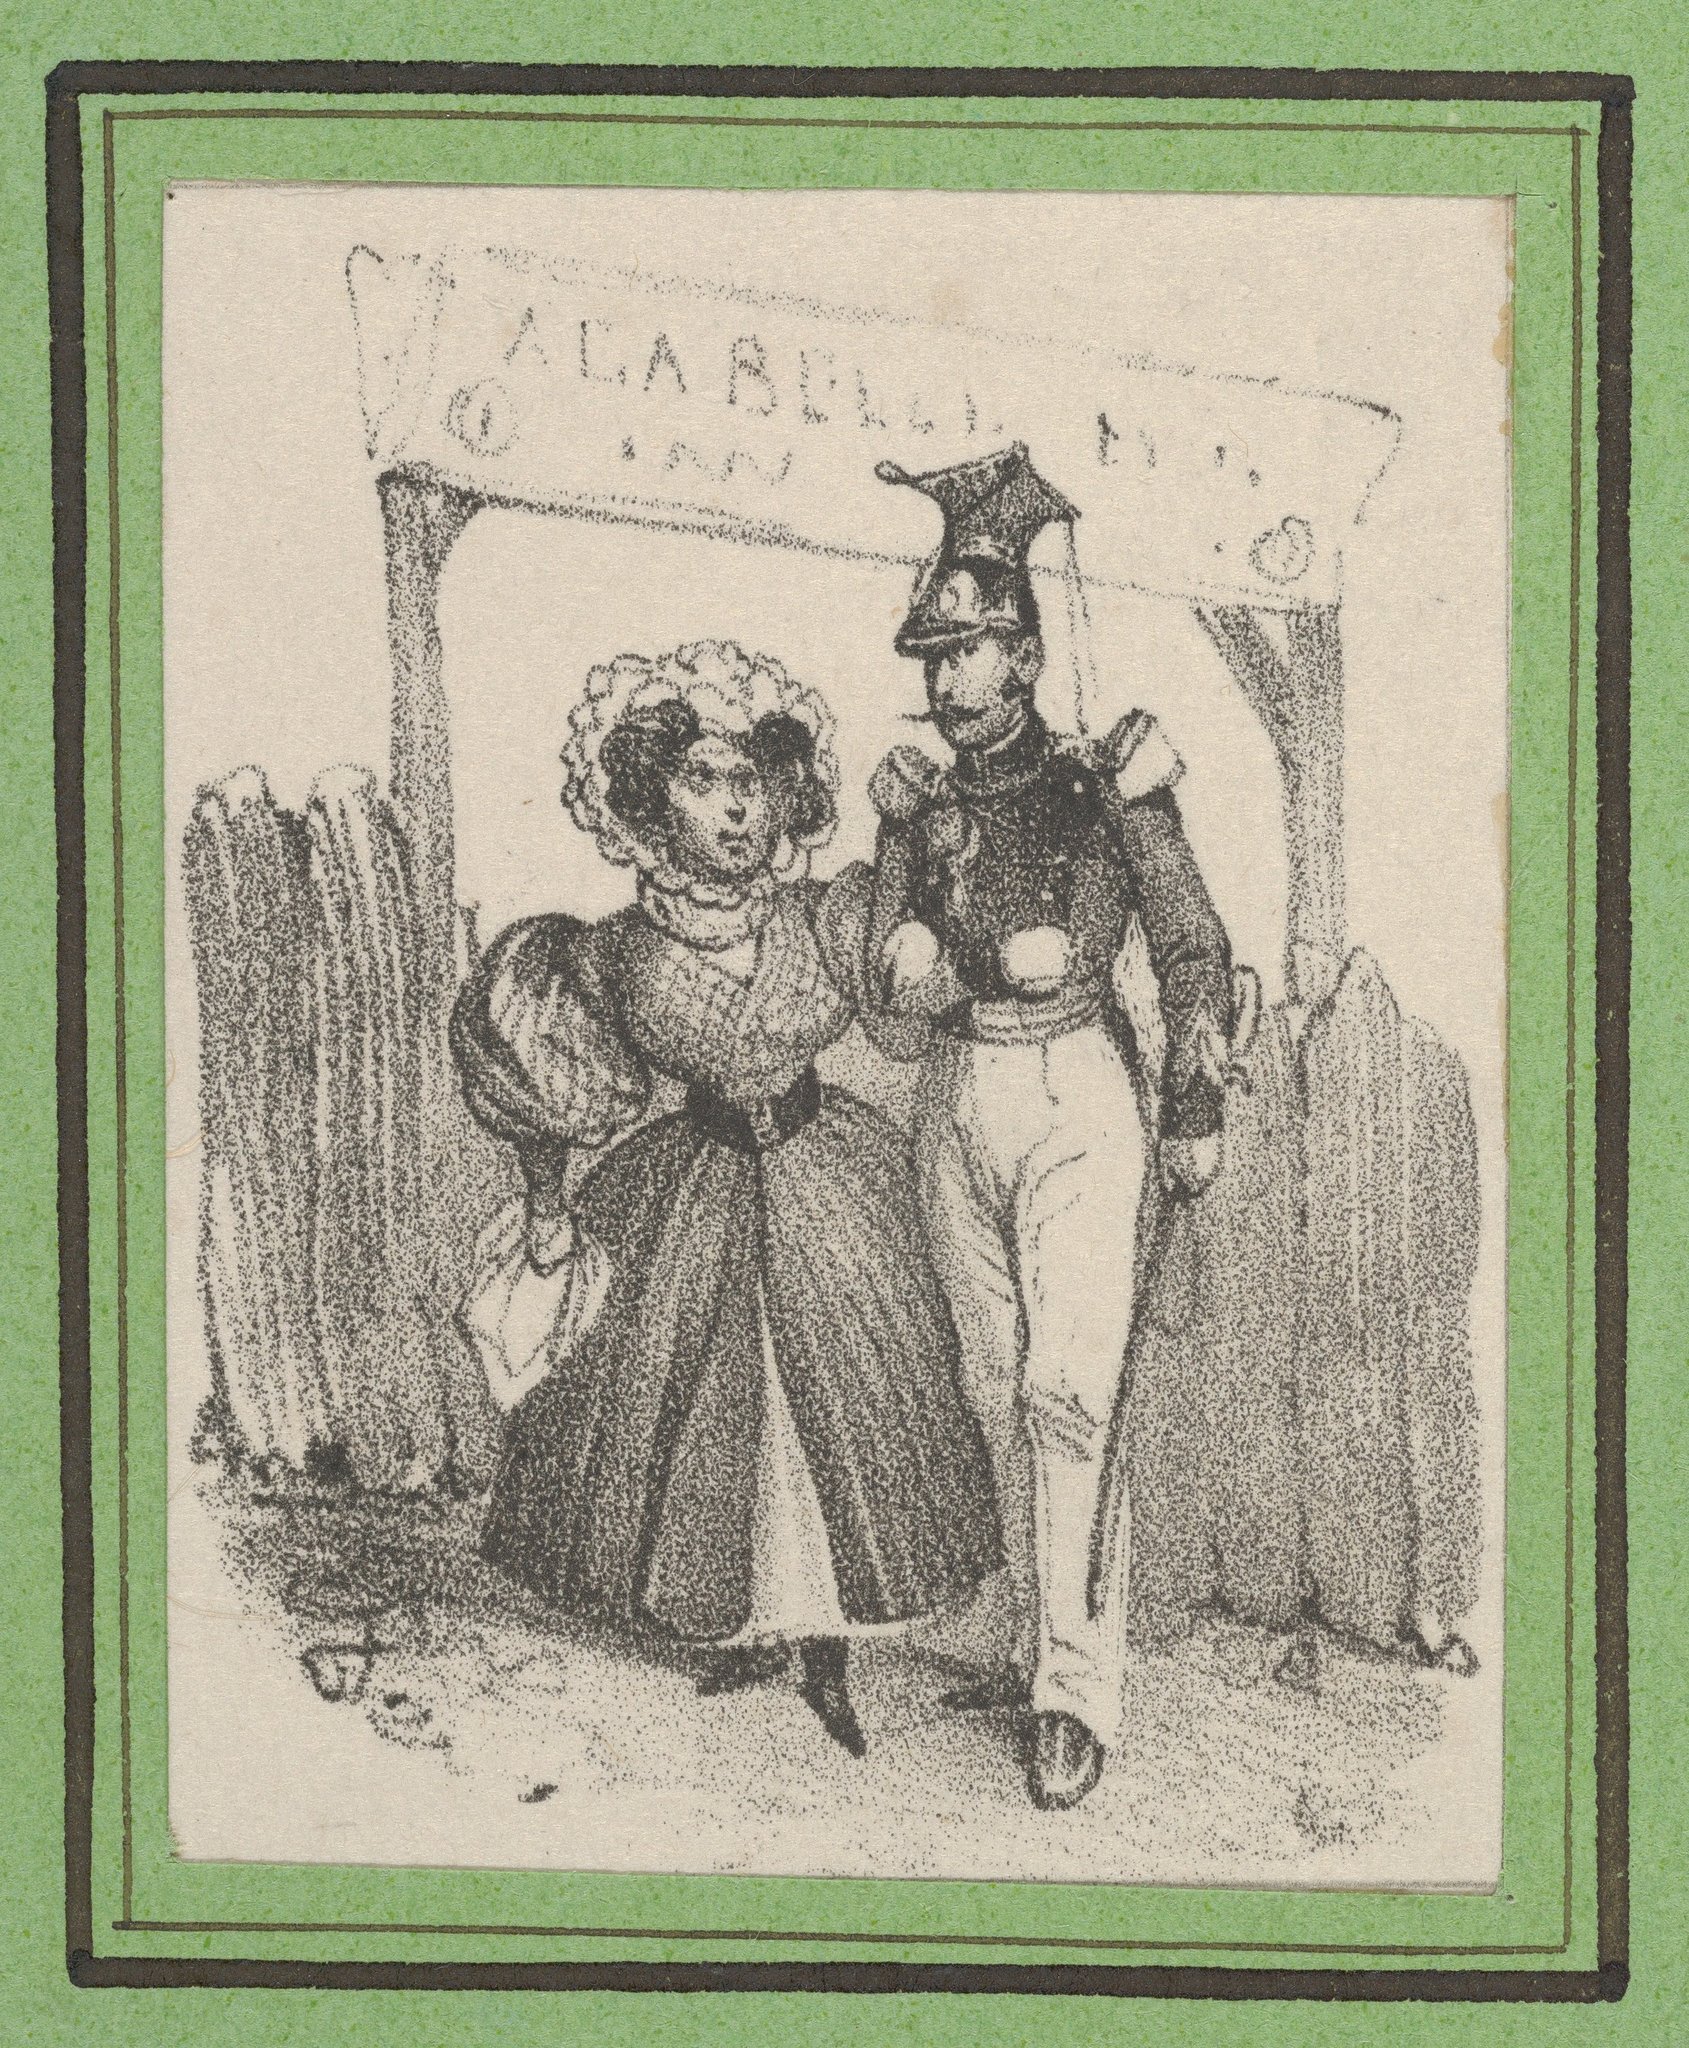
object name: print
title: Soldier with a woman on his arm in front of a wodden gate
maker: victor adam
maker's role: artist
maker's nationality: french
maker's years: 1801-1866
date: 1834-1866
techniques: lithograph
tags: gates,soldiers,portraits,women